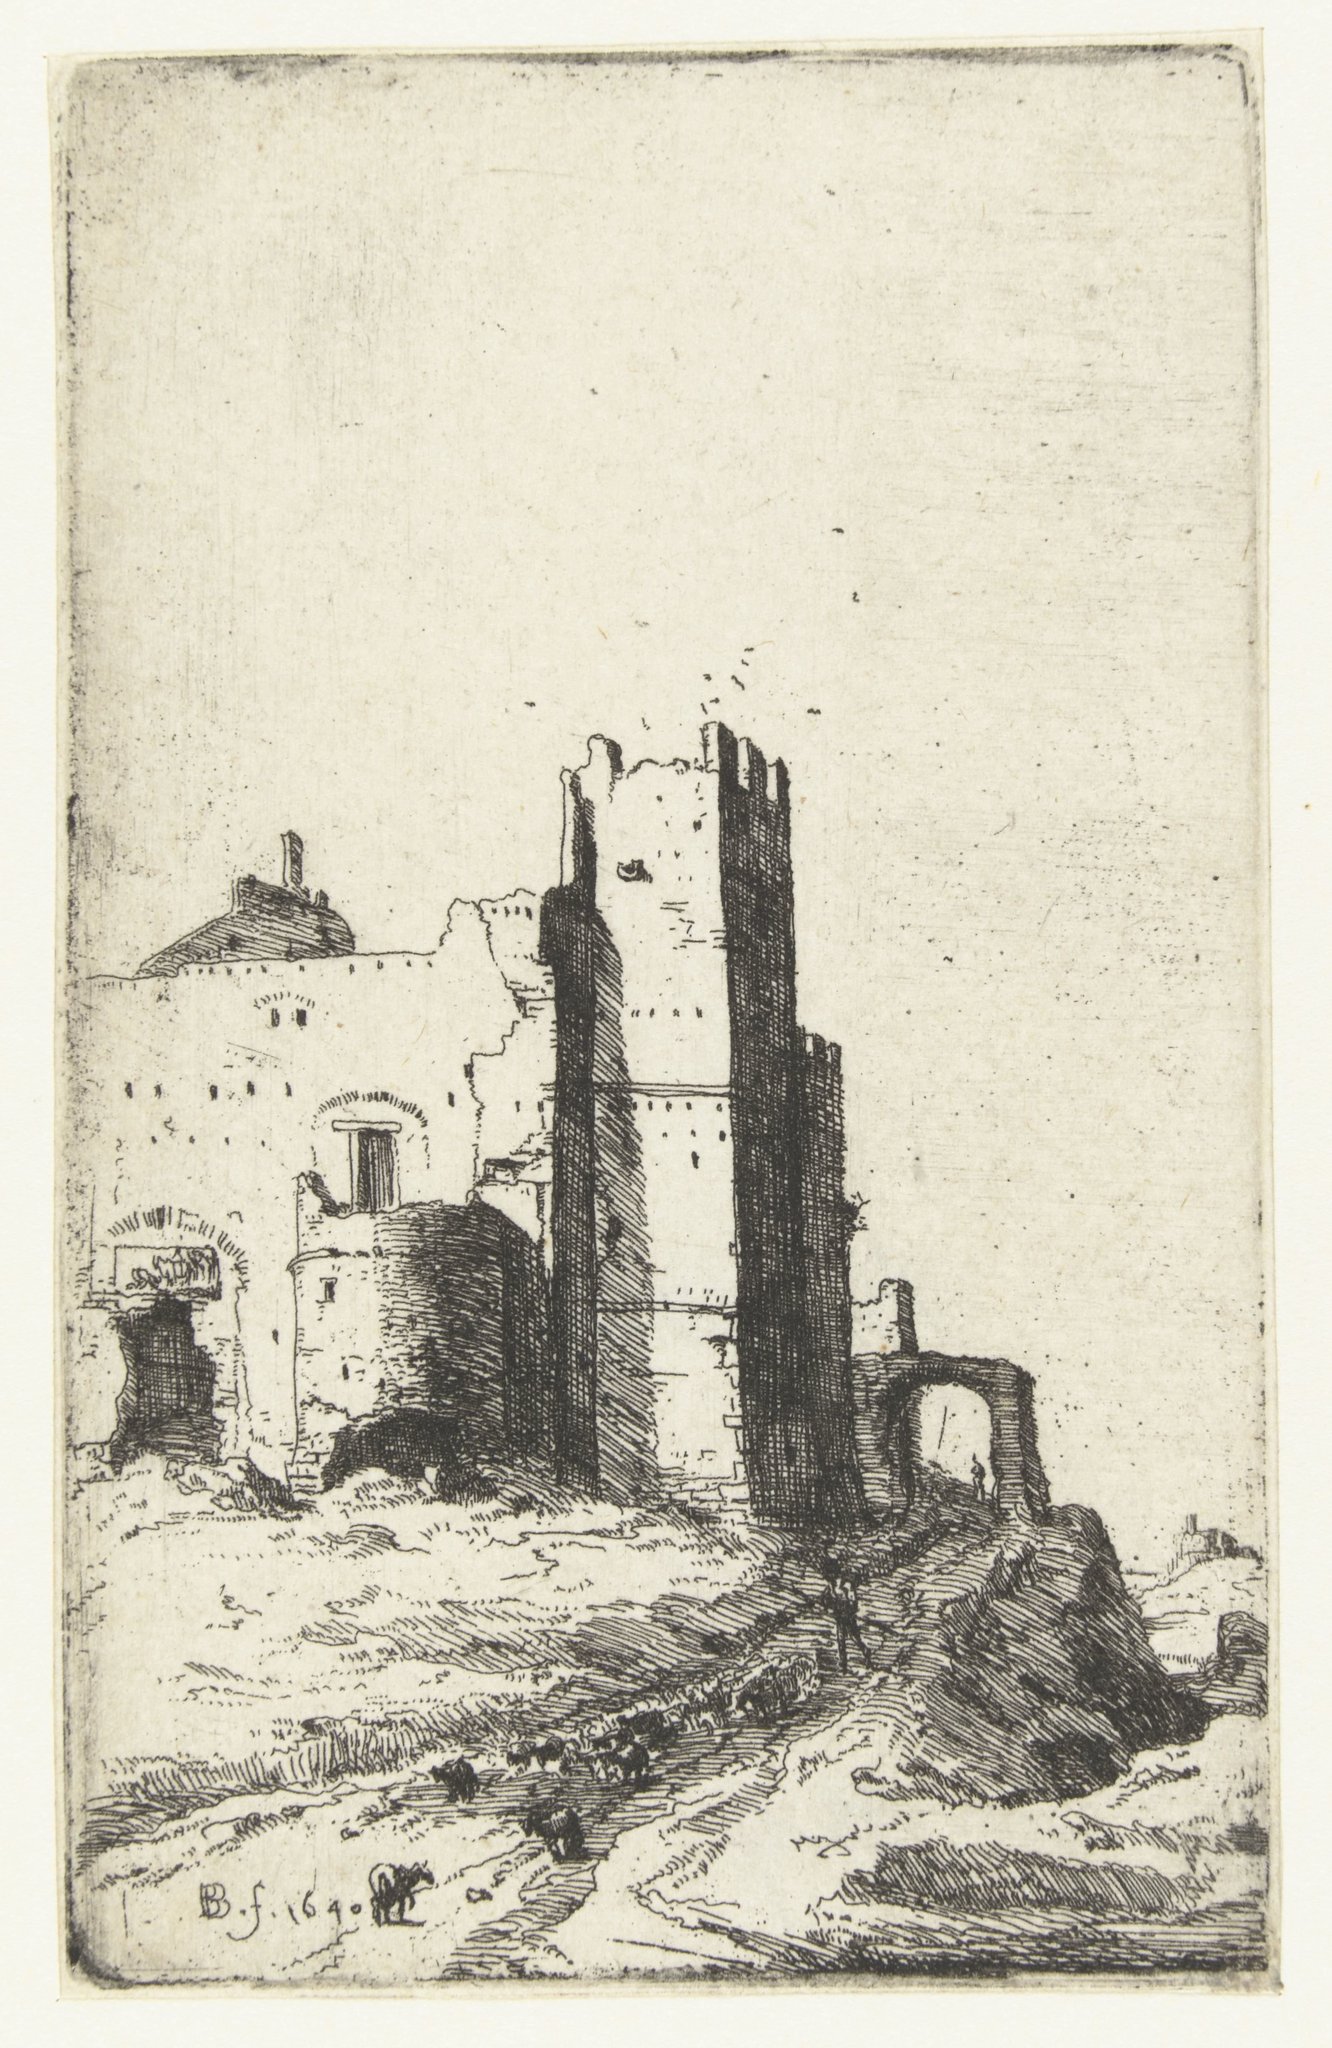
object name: print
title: Romeinse ruïnes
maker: bartholomeus breenbergh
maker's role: draughtsman, print maker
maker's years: 1599-1657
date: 1640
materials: paper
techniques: etching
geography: netherlands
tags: landscape with ruins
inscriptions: collector's mark: Lugt 240